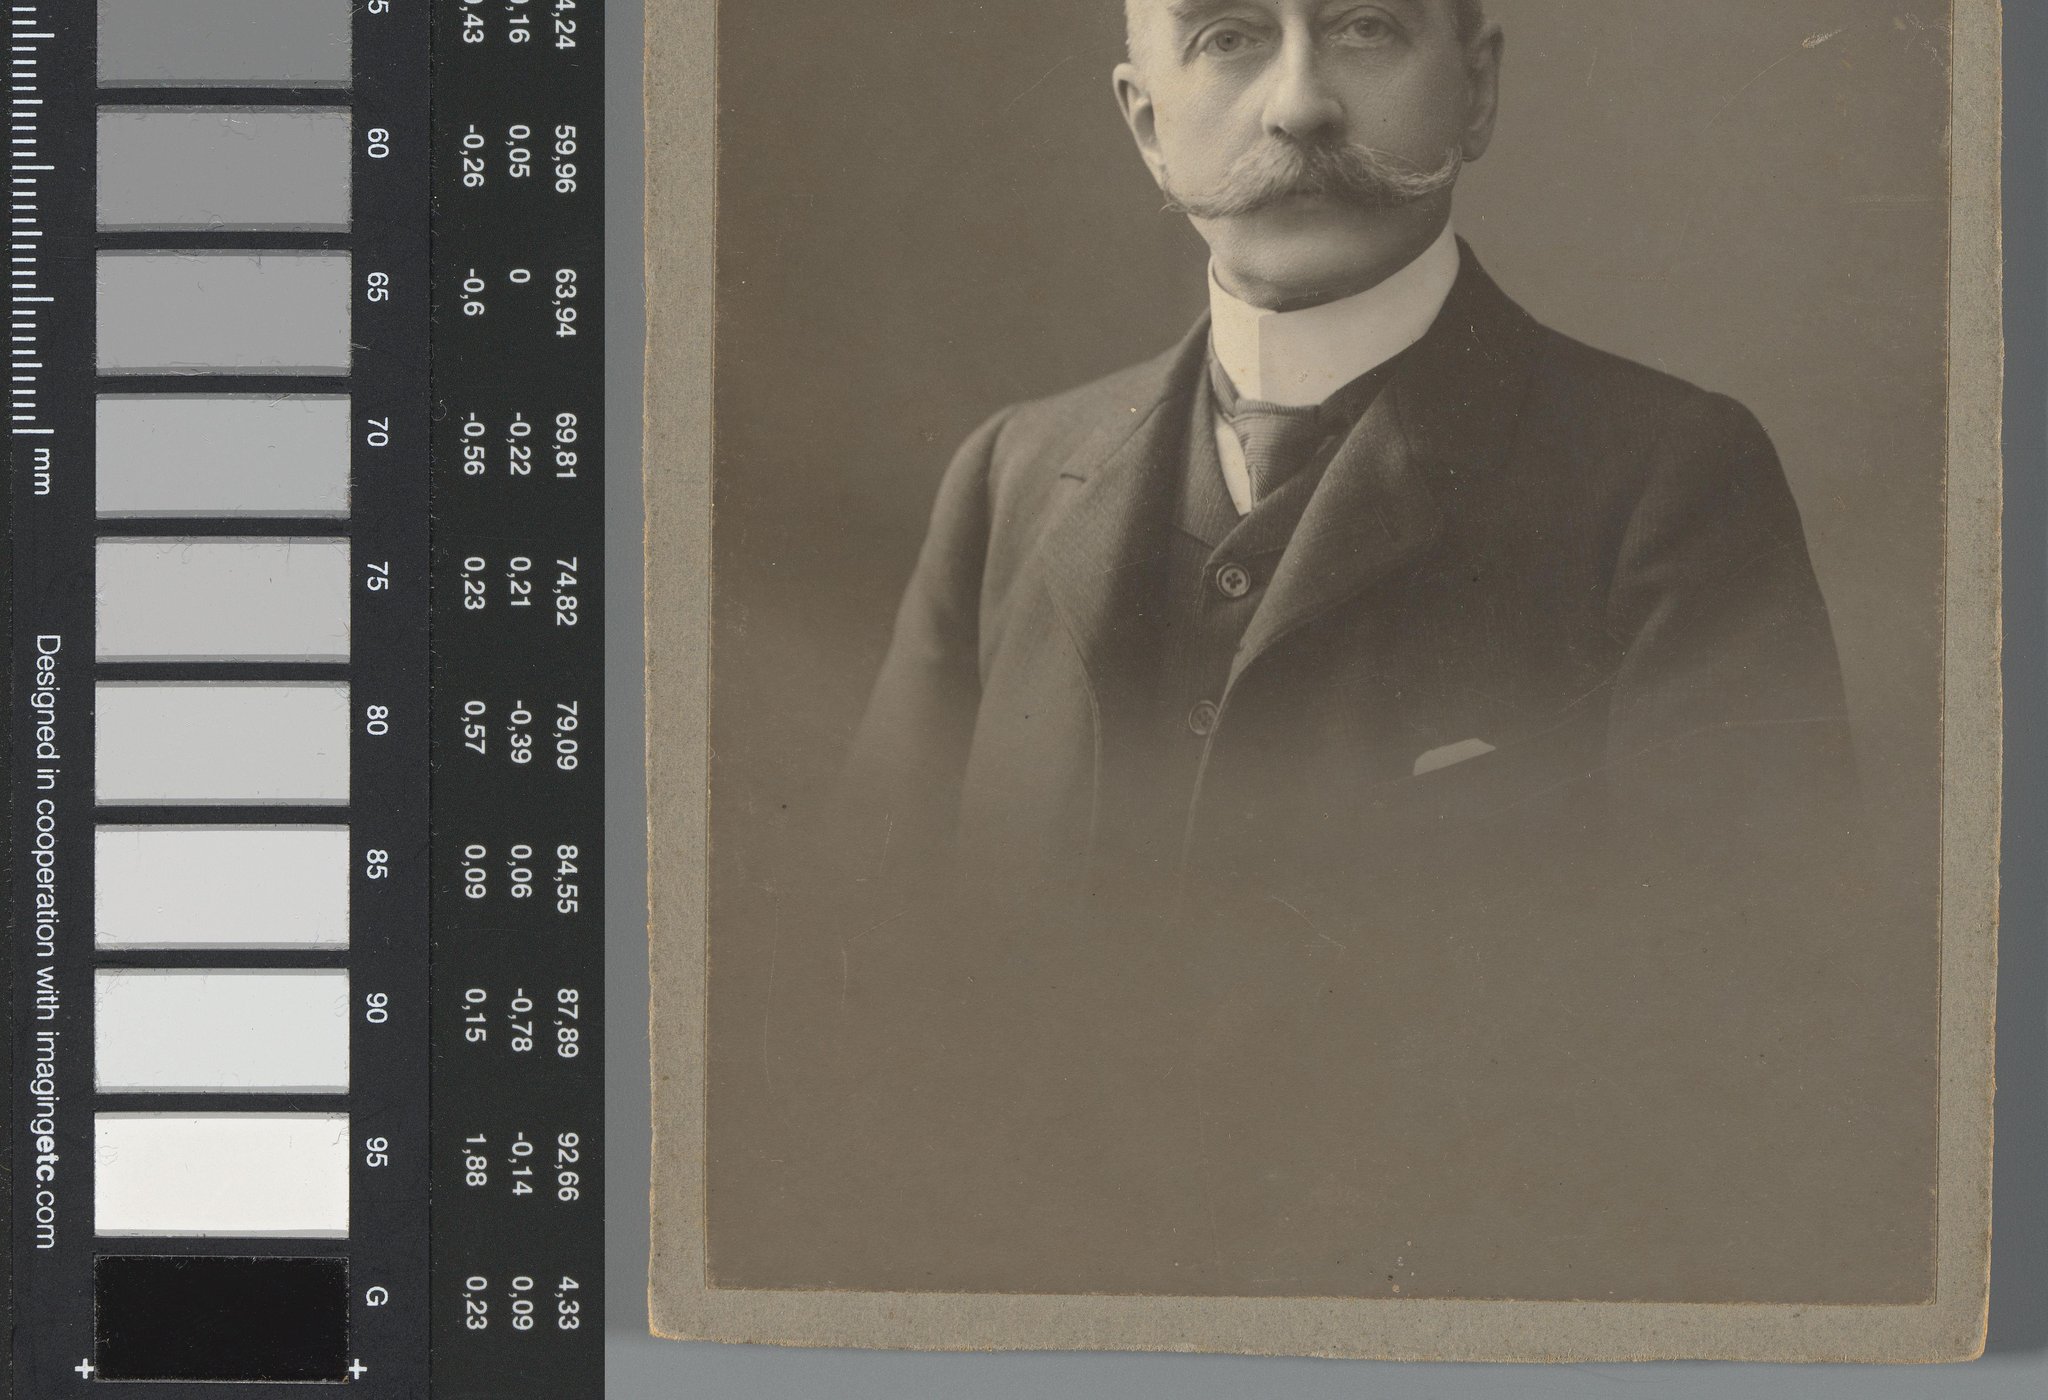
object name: cabinet photograph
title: Studioportret van Piet Onnen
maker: Anonymous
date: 1890-1920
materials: cardboard, photographic support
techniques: albumen print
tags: pieter jan gerard onnen